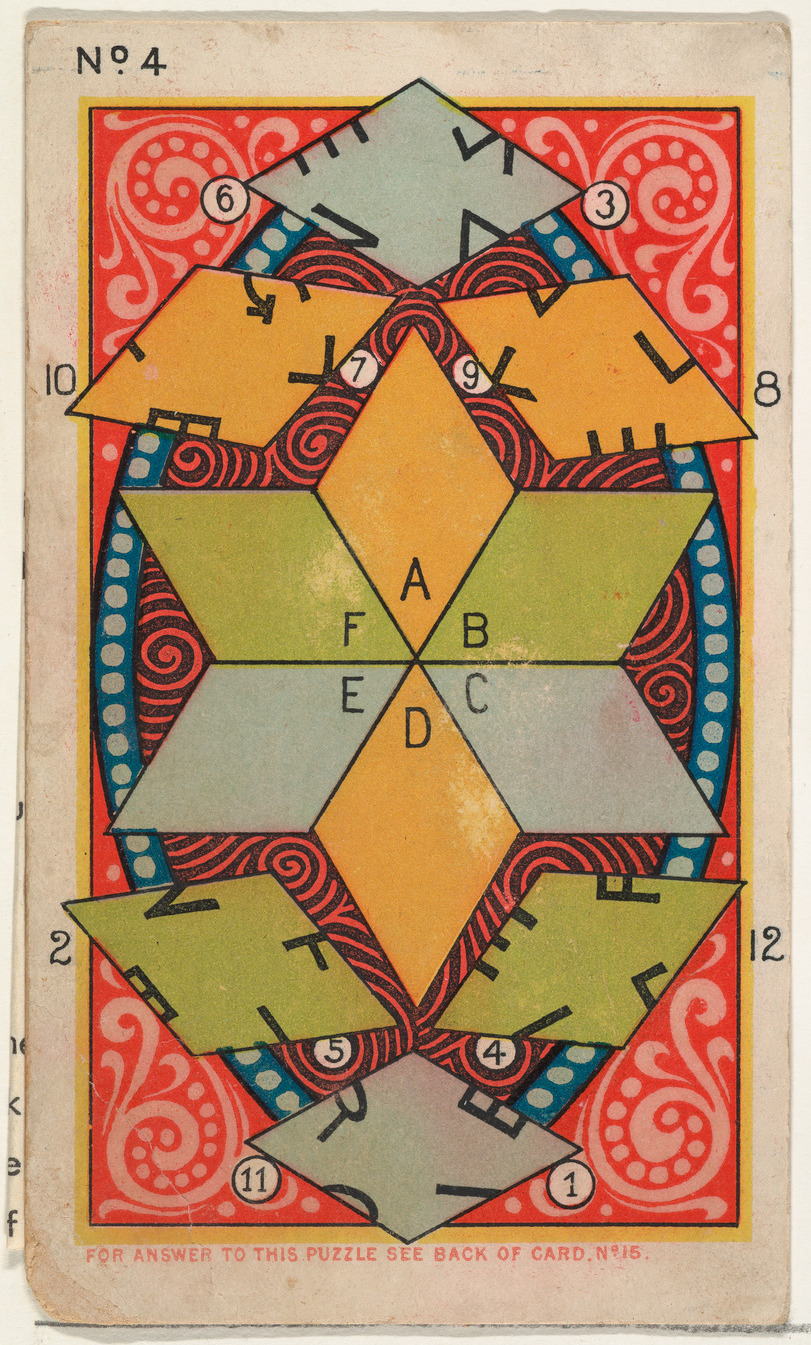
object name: print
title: Puzzle Card Number 4, from the Jokes series (N118) issued by Duke Sons & Co. to promote Honest Long Cut Tobacco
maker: w. duke, sons & co.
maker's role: publisher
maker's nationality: american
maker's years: 1870-1920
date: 1890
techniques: color lithograph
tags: playing cards